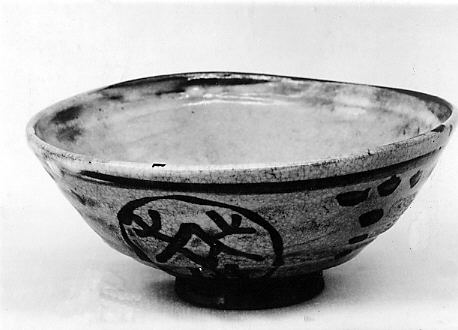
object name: teabowl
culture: japanese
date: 1801-1900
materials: clay, glaze